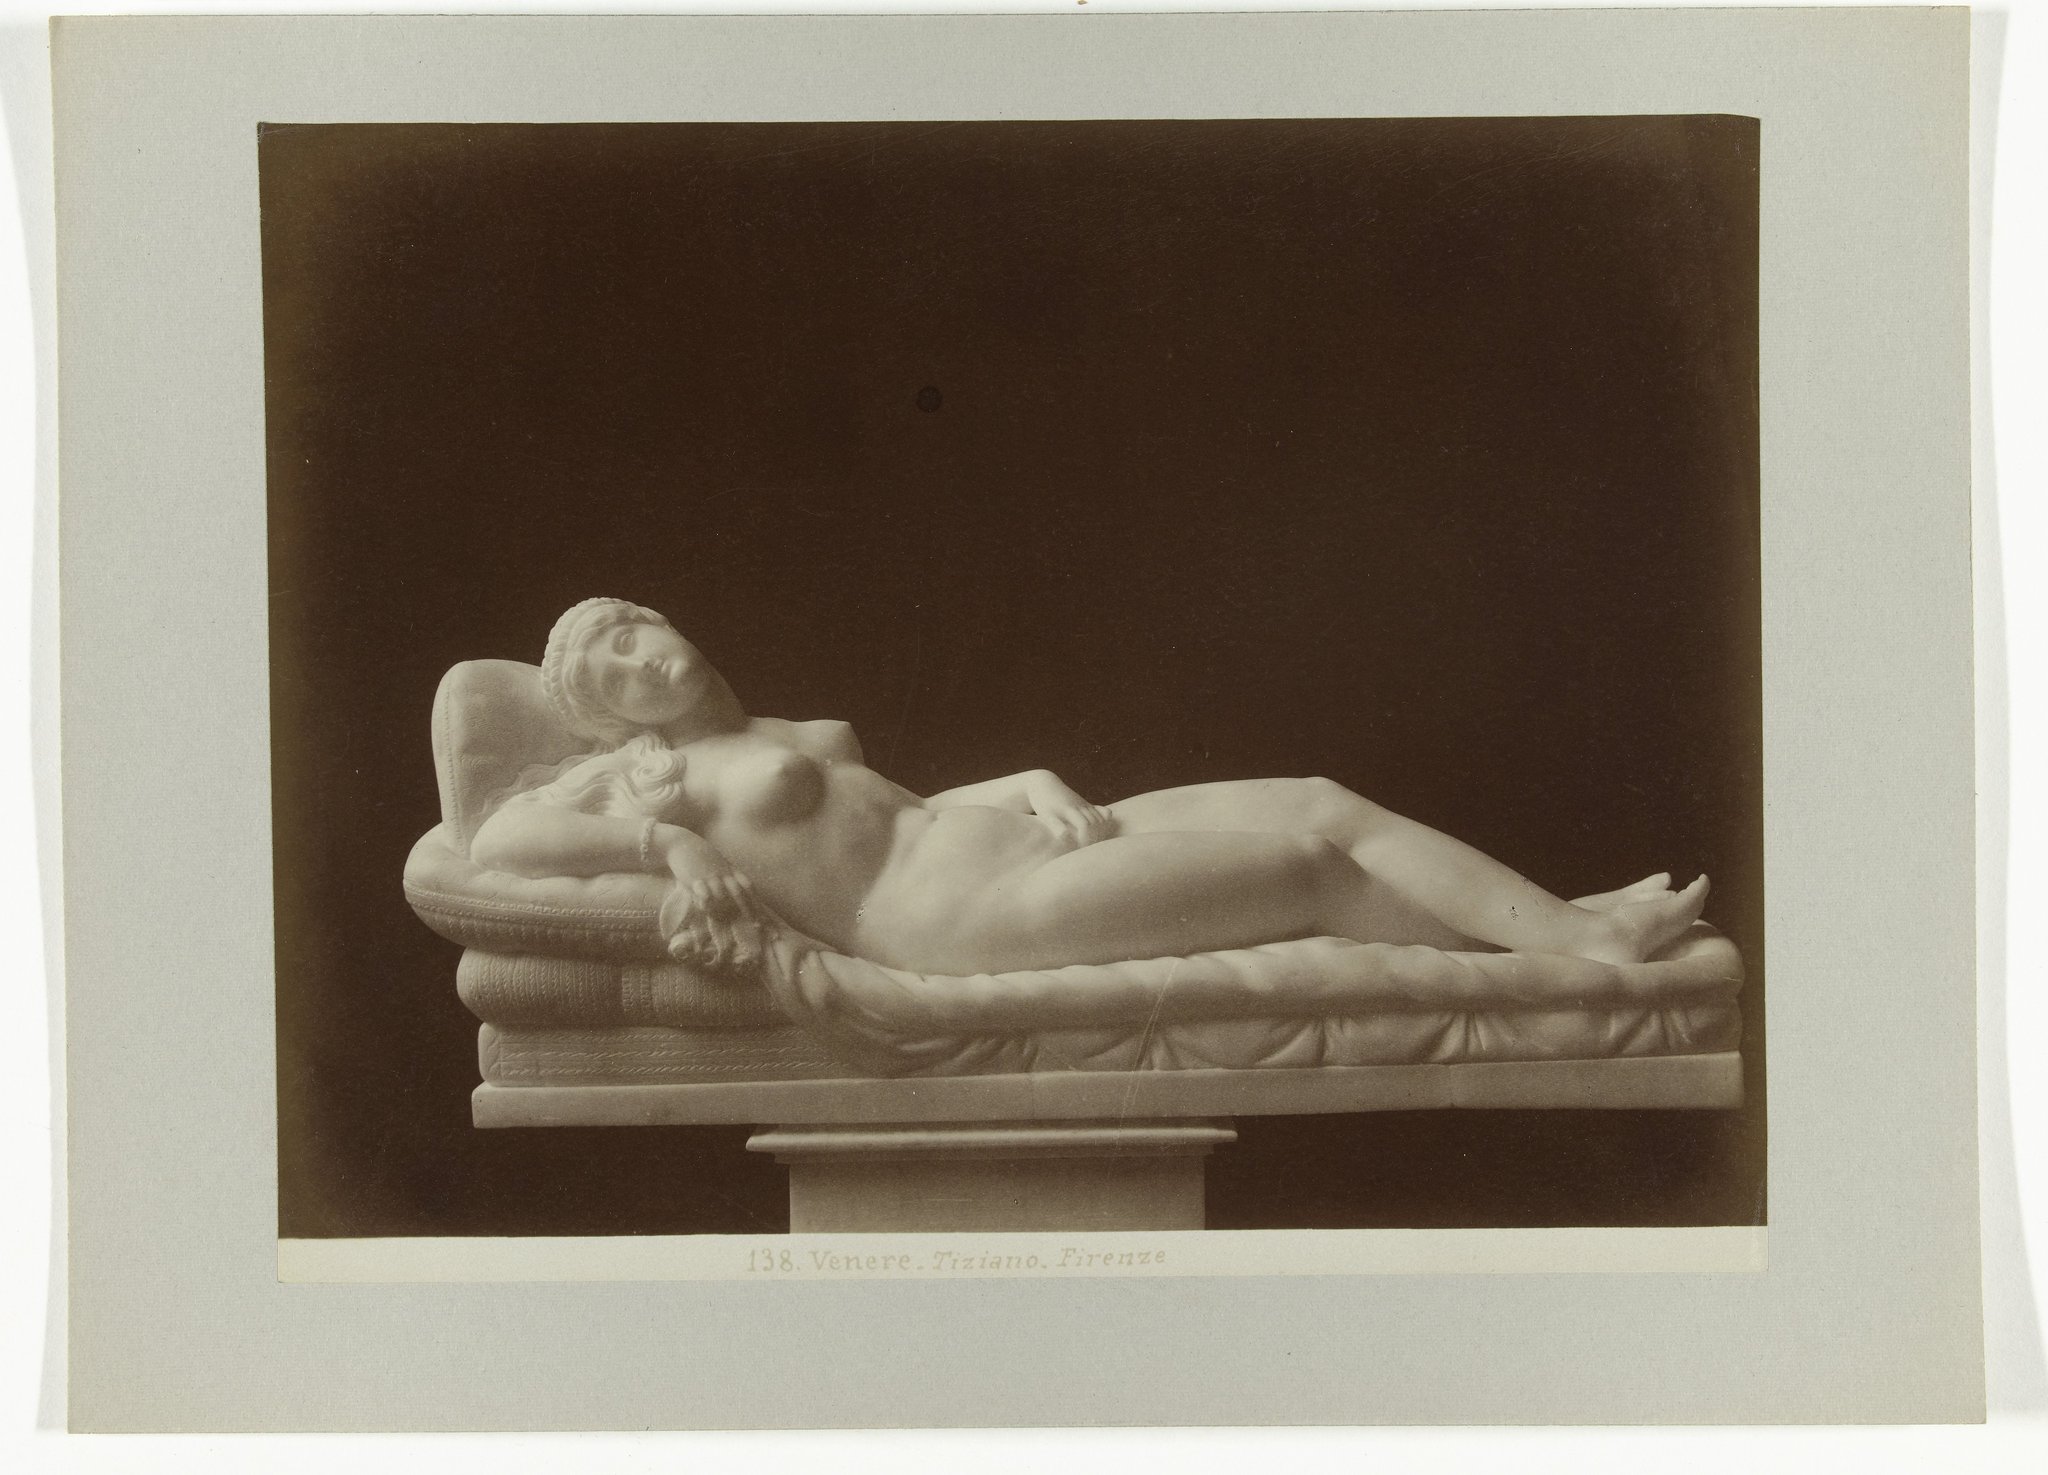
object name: photograph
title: Sculptuur van liggende Venus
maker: Anonymous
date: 1880-1904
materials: cardboard, paper, photographic support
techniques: albumen print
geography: florence